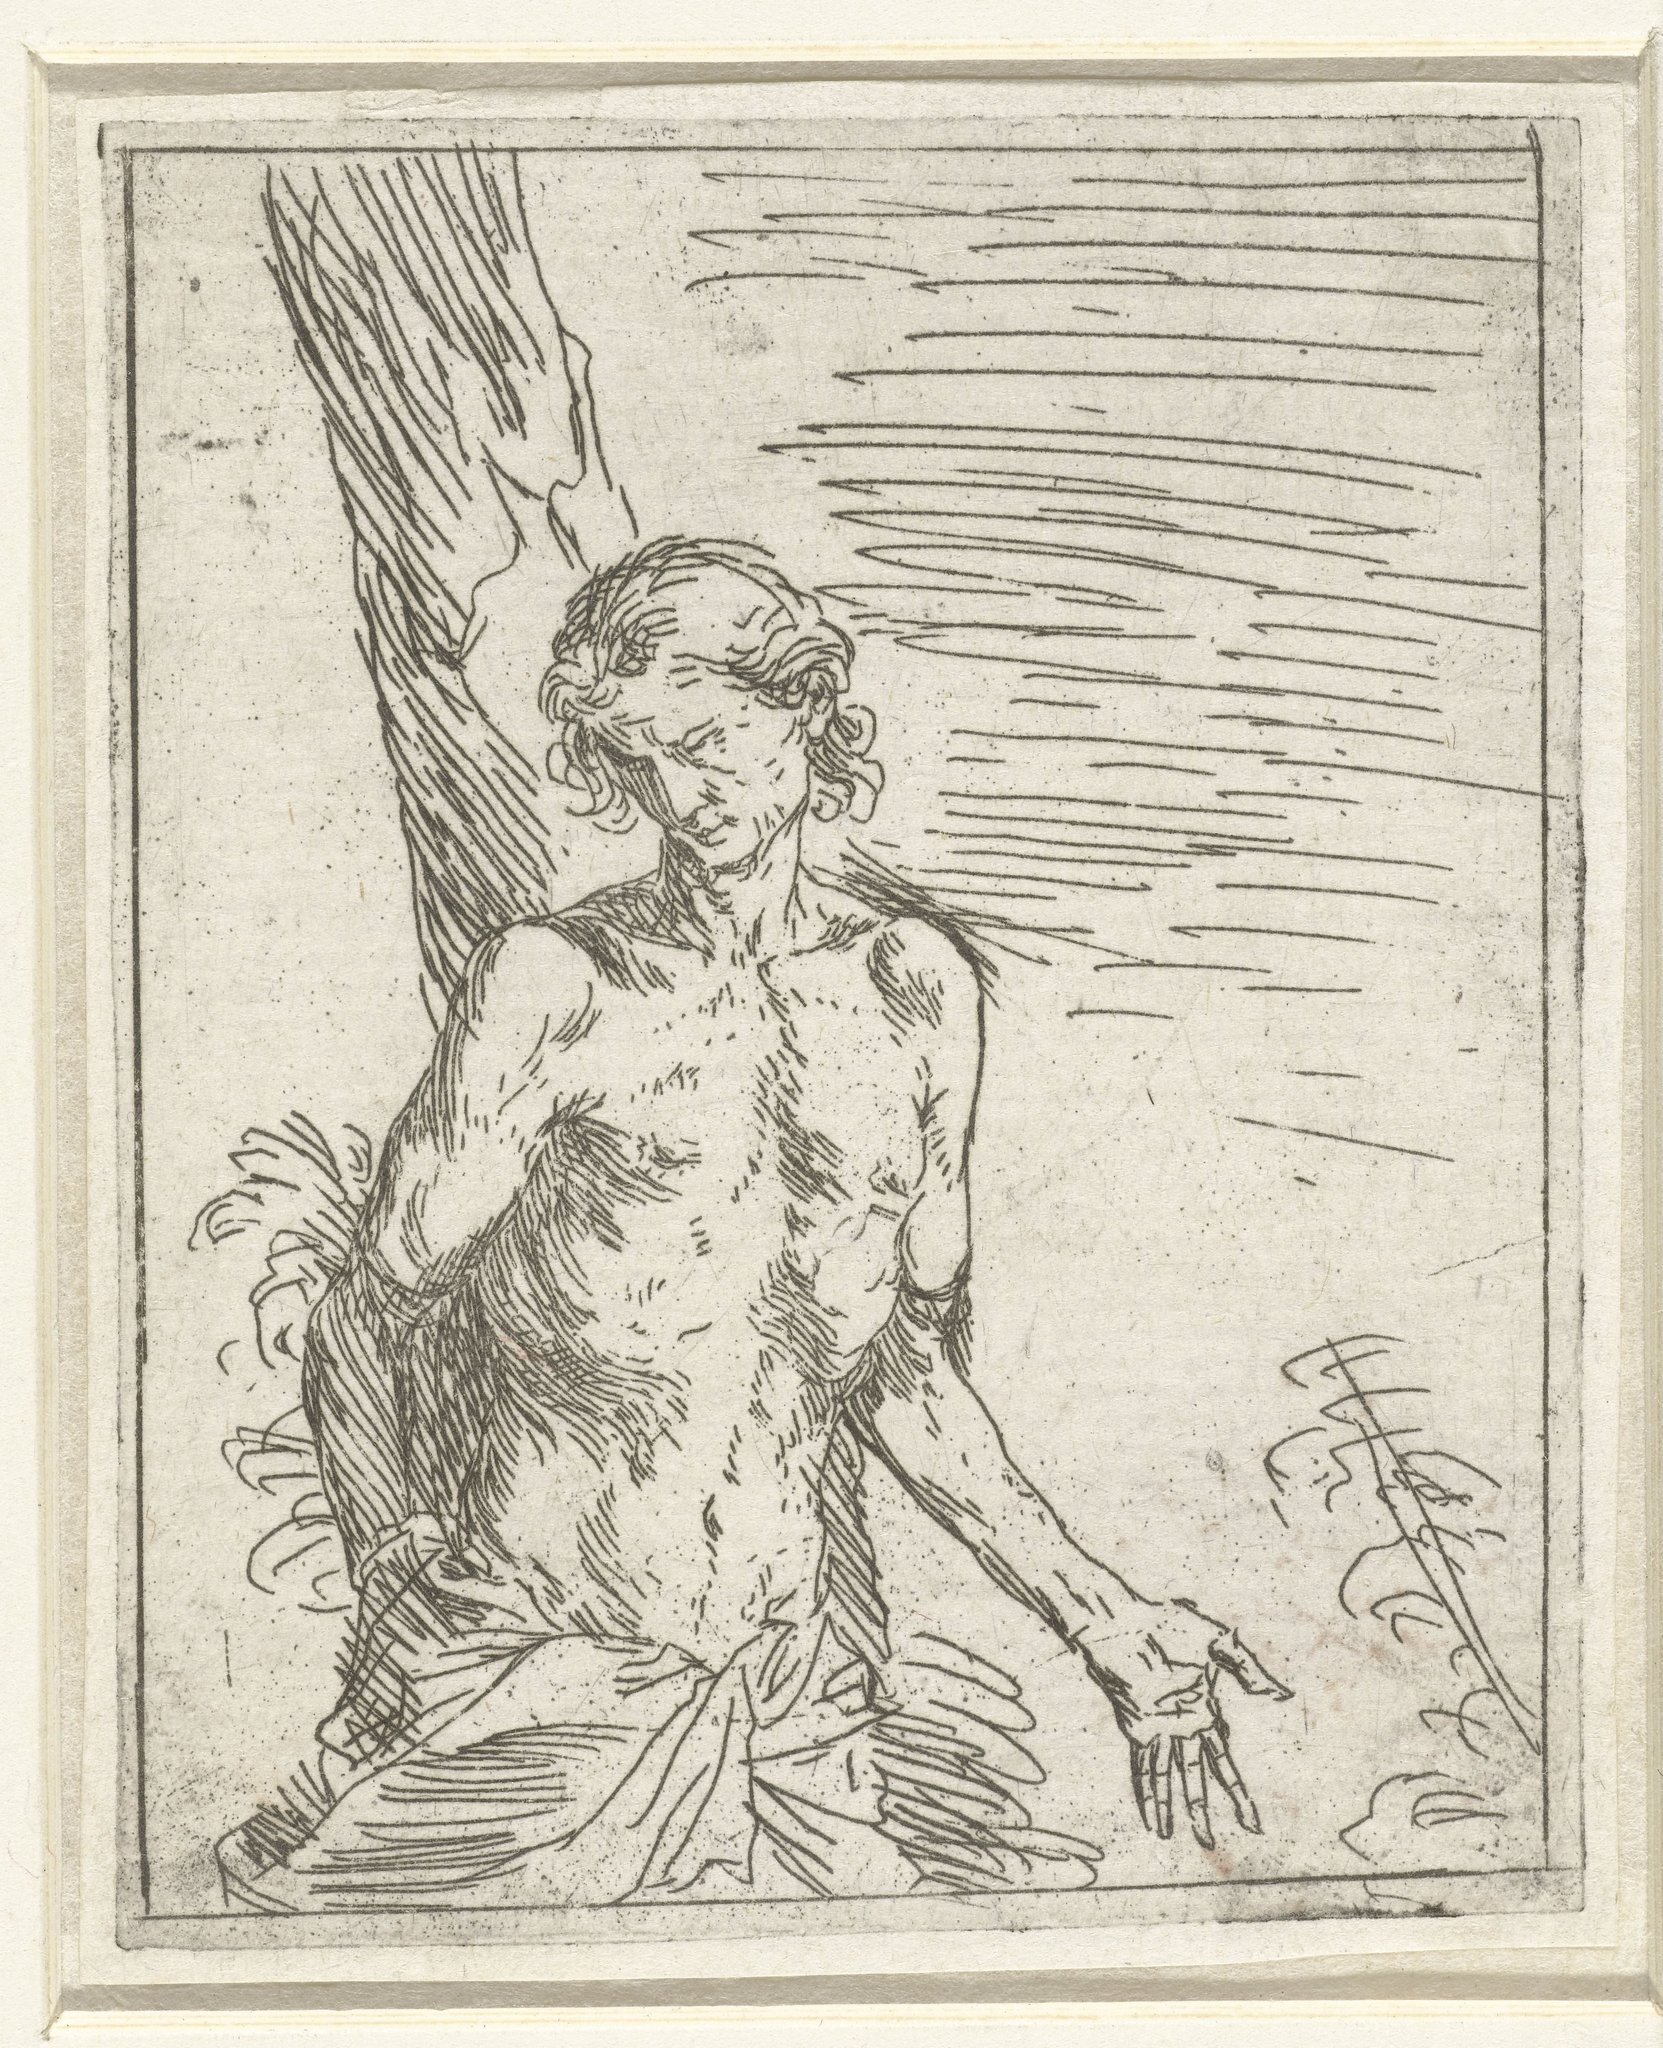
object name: print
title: Heilige Sebastiaan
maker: jusepe de ribera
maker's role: draughtsman, painter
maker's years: 1591-1652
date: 1618-1622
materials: paper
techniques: etching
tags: the martyr sebastian; possible attributes: arrow(s), bow, tree-trunk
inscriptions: collector's mark: Lugt 240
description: De heilige Sebastiaan, ten halven lijve, tegen een boom.